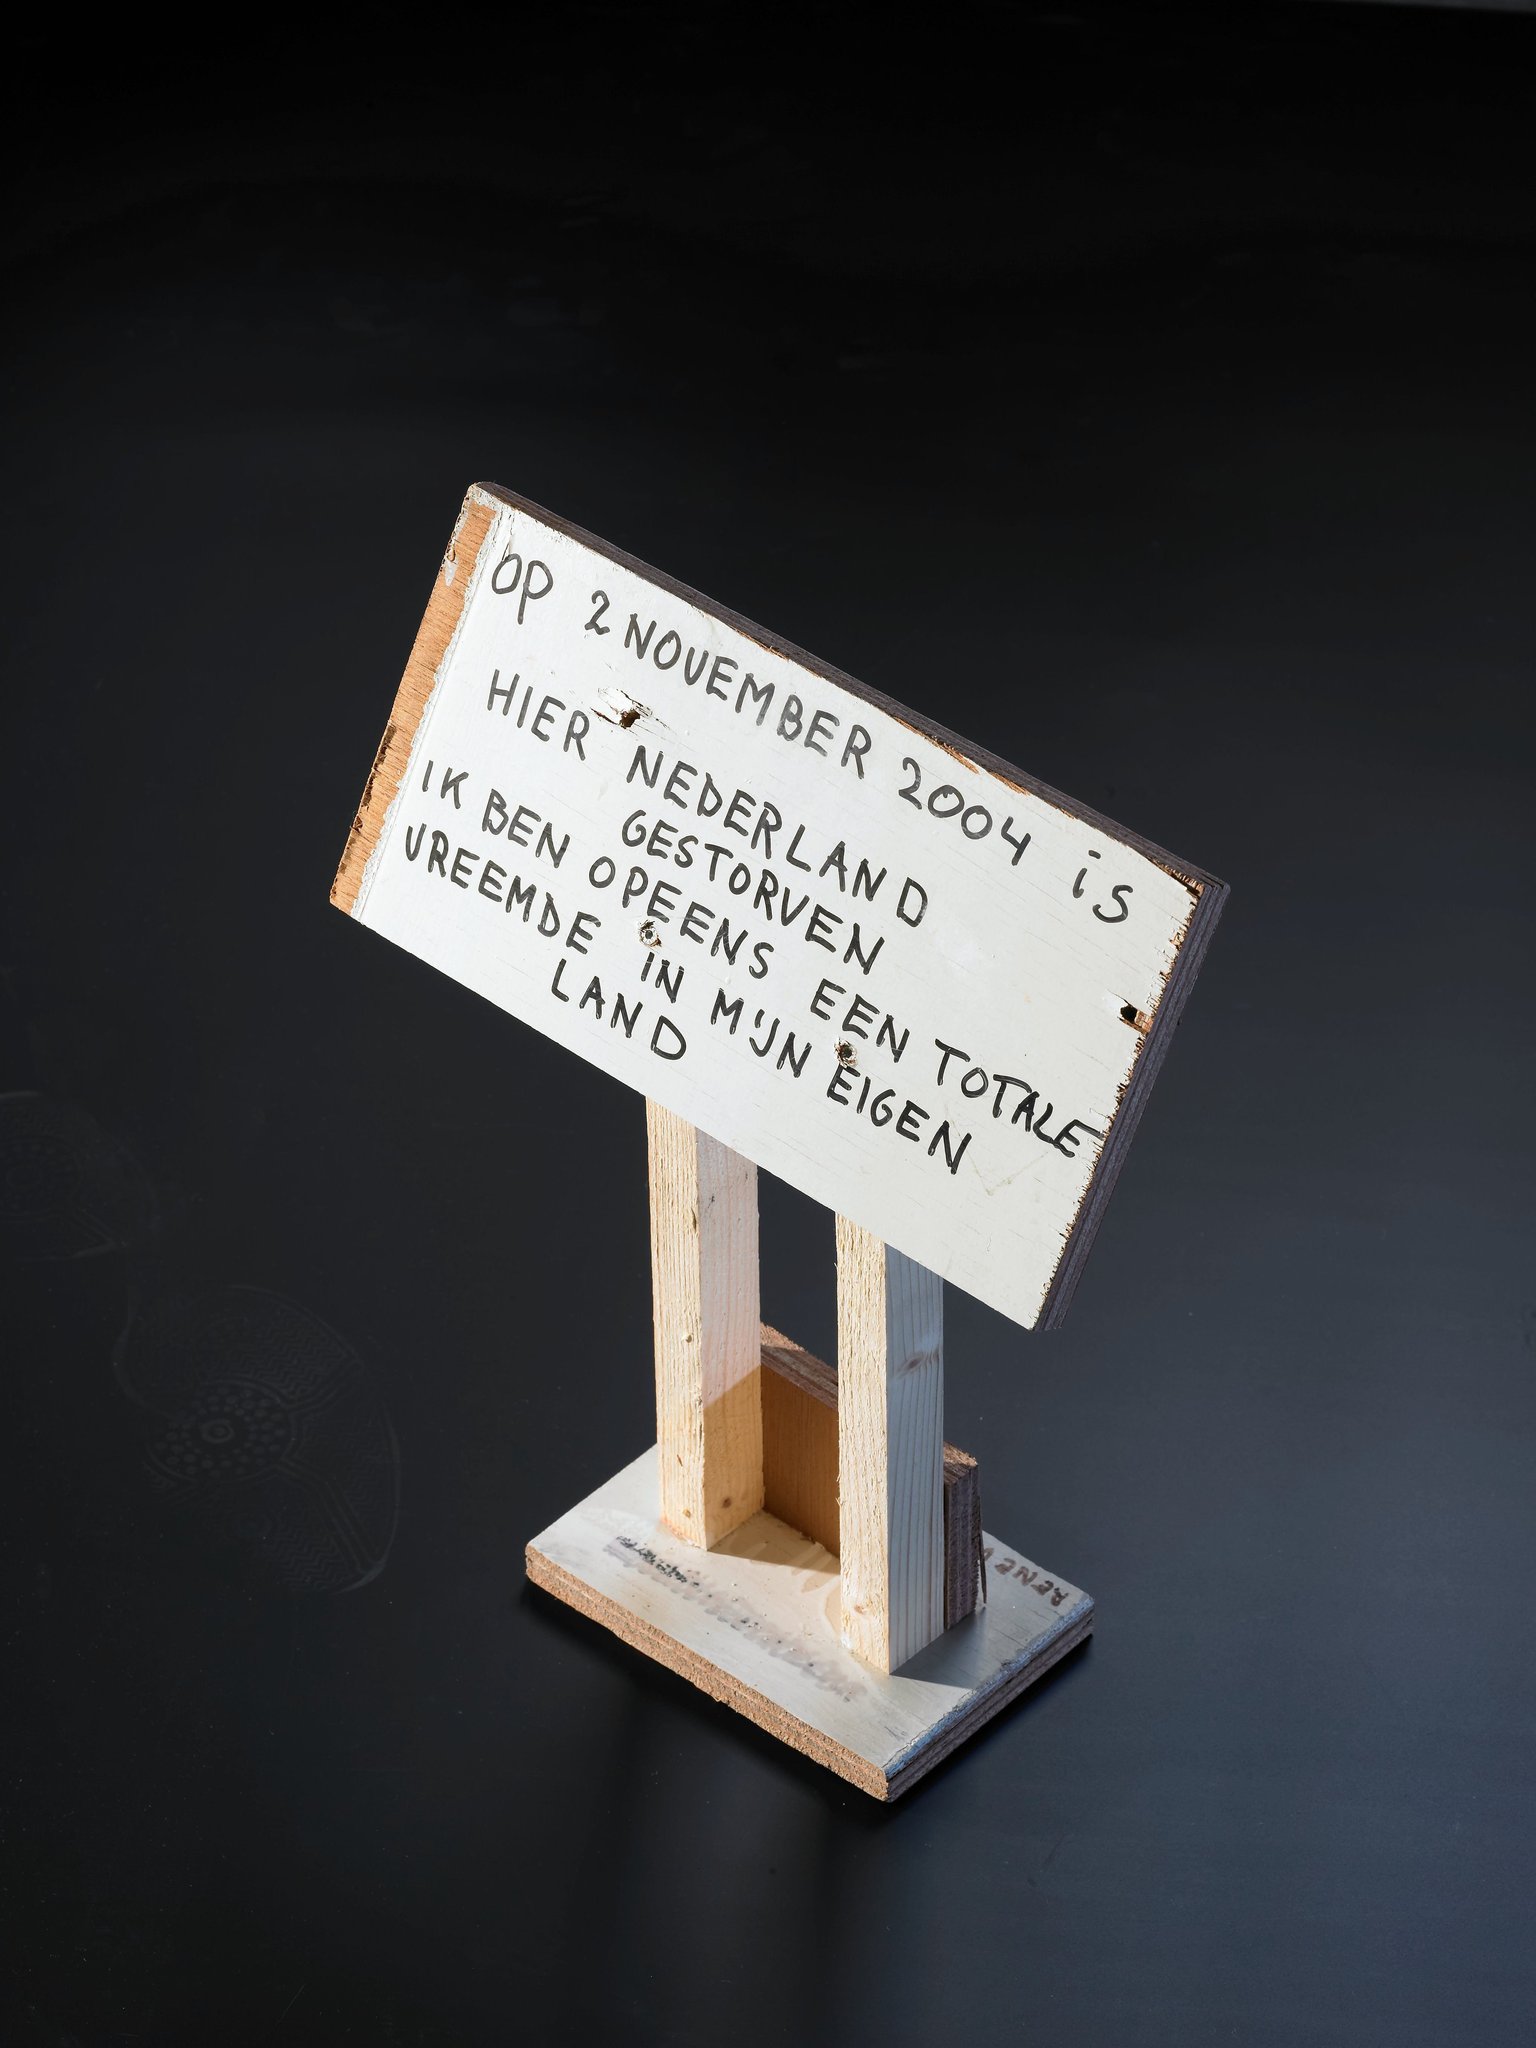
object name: information sign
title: Houten bordje met tekst over de moord op Theo van Gogh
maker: ruud veenis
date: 2004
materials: wood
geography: utrecht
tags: the hague, theo van gogh, amsterdam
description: Houten bordje bevestigd aan twee balkjes, geheel rust weer op plankje. Geschreven opschrift: "Op 2 november 2004 is hier Nederland gestorven. Ik ben opeens een totale vreemde in mijn eigen land" Achterkant: "De dader krijgt een eerlijk proces en wij voor de zoveelste maal levenslang" Op het bodemplankje: Ruud Veenis - Utrecht.